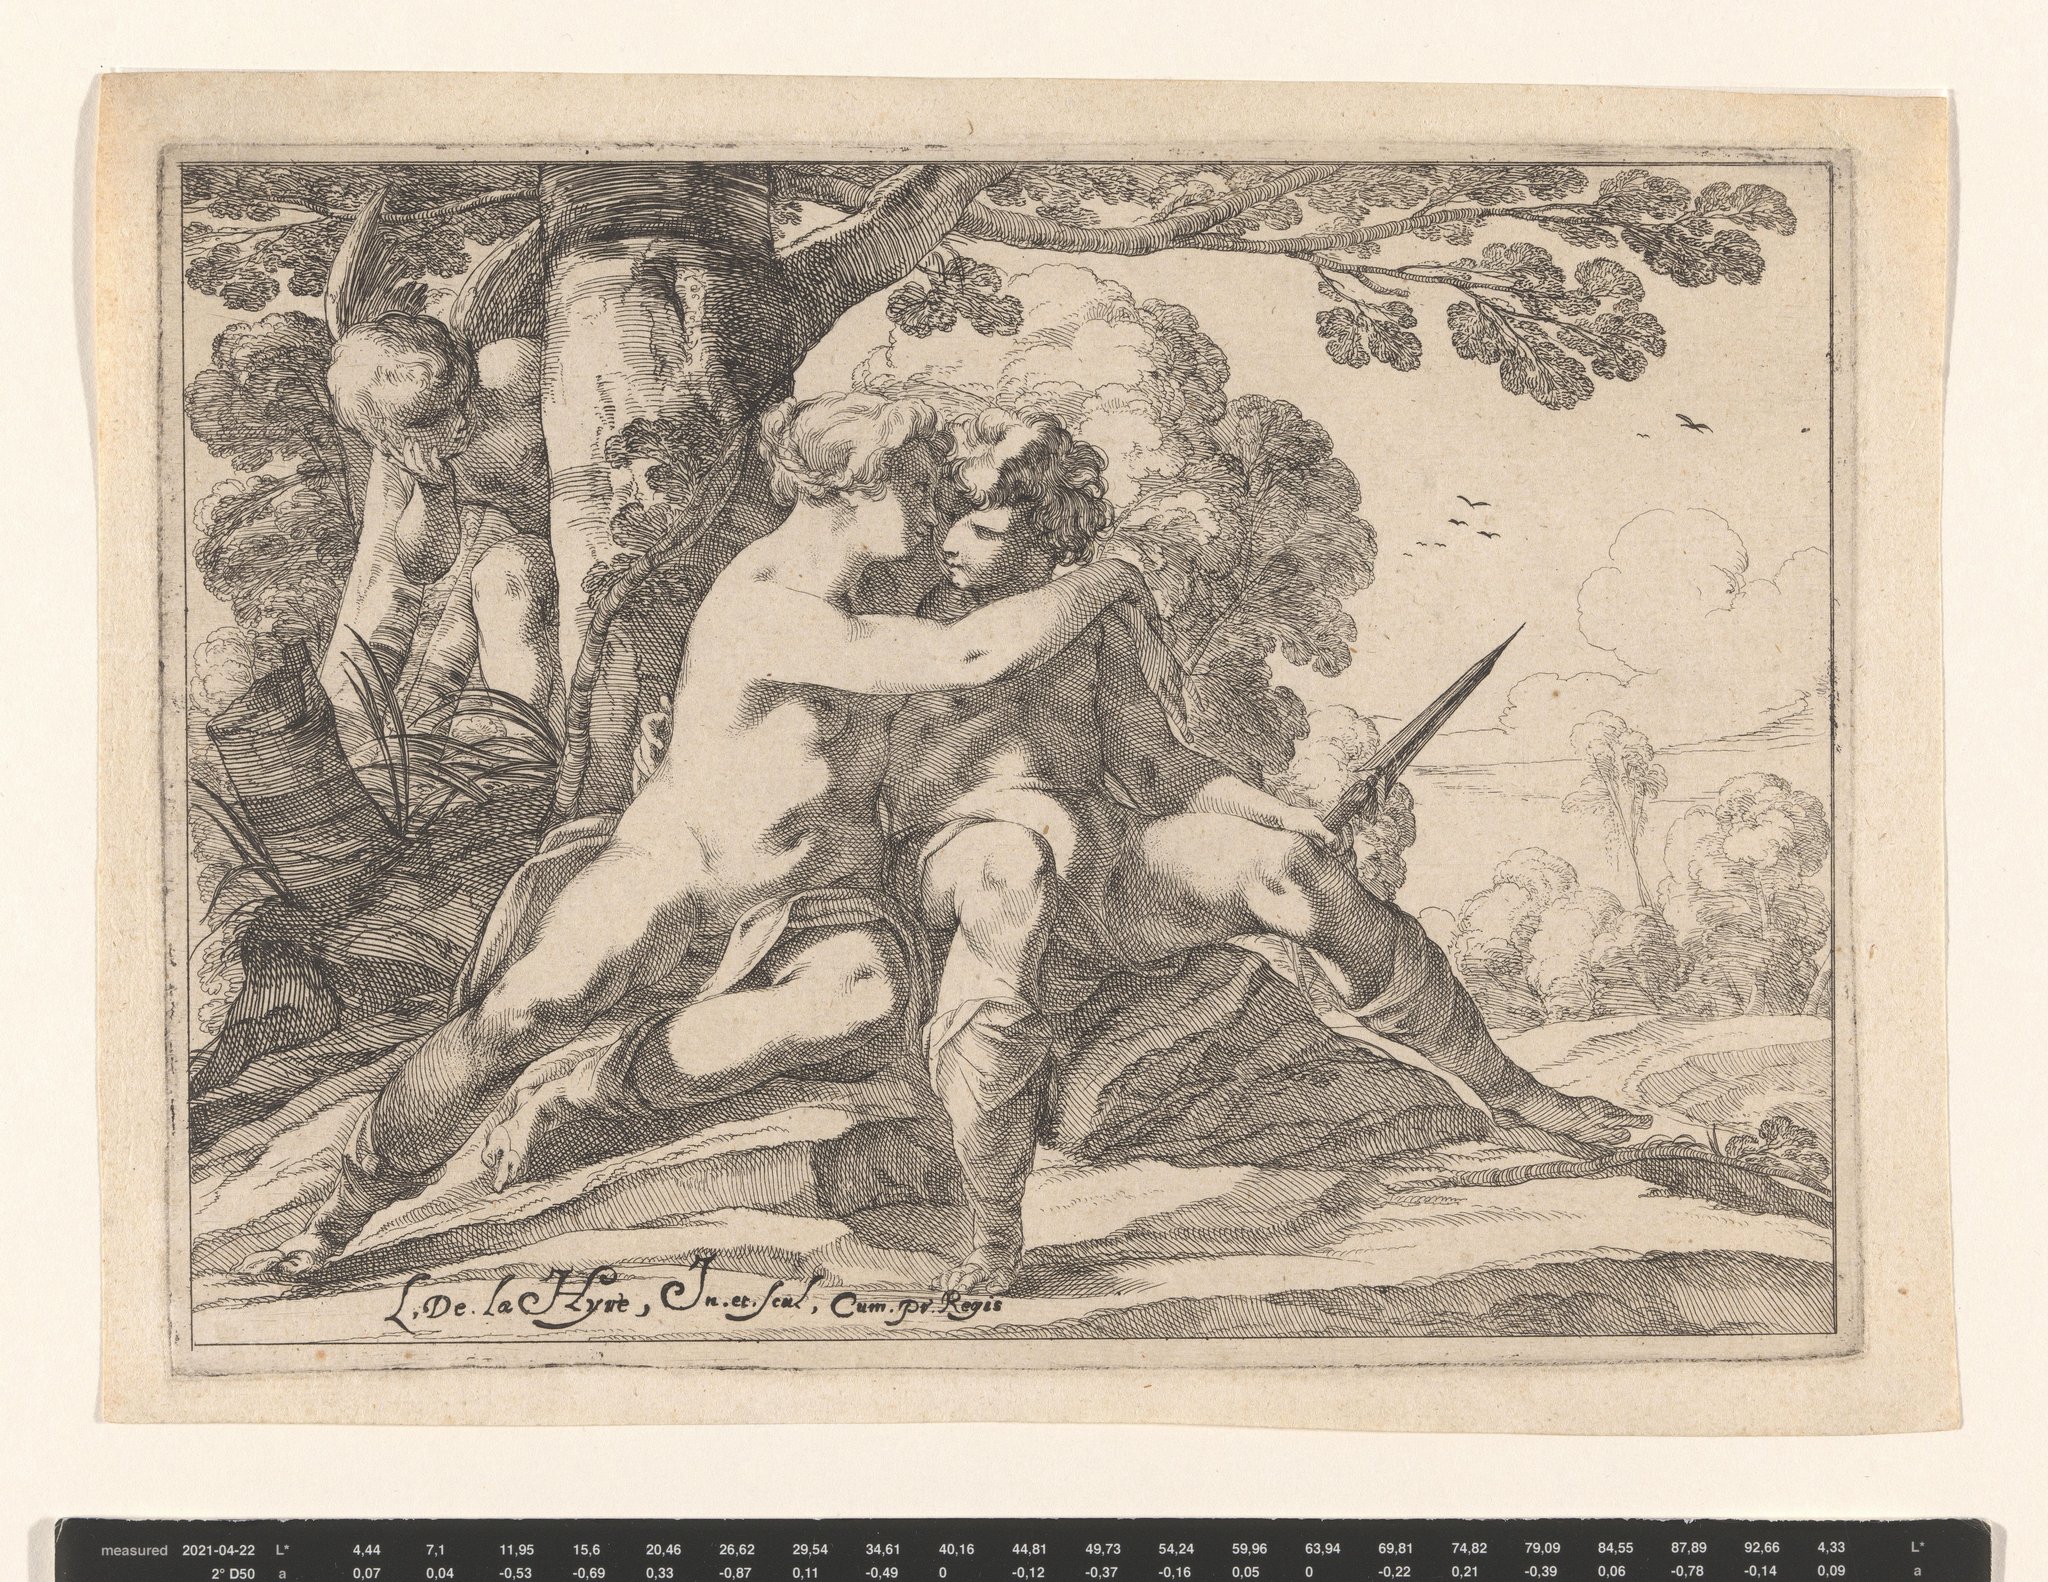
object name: print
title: Venus en Adonis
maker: laurent de la hire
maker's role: draughtsman, painter, print maker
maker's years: 1606-1656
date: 1630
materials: paper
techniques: etching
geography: paris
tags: venus and adonis as lovers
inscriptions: collector's mark: Lugt 2228, collector's mark: Lugt 2760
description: Venus en Adonis in omhelzing onder een boom, Cupido kijkt vanachter de boom toe.